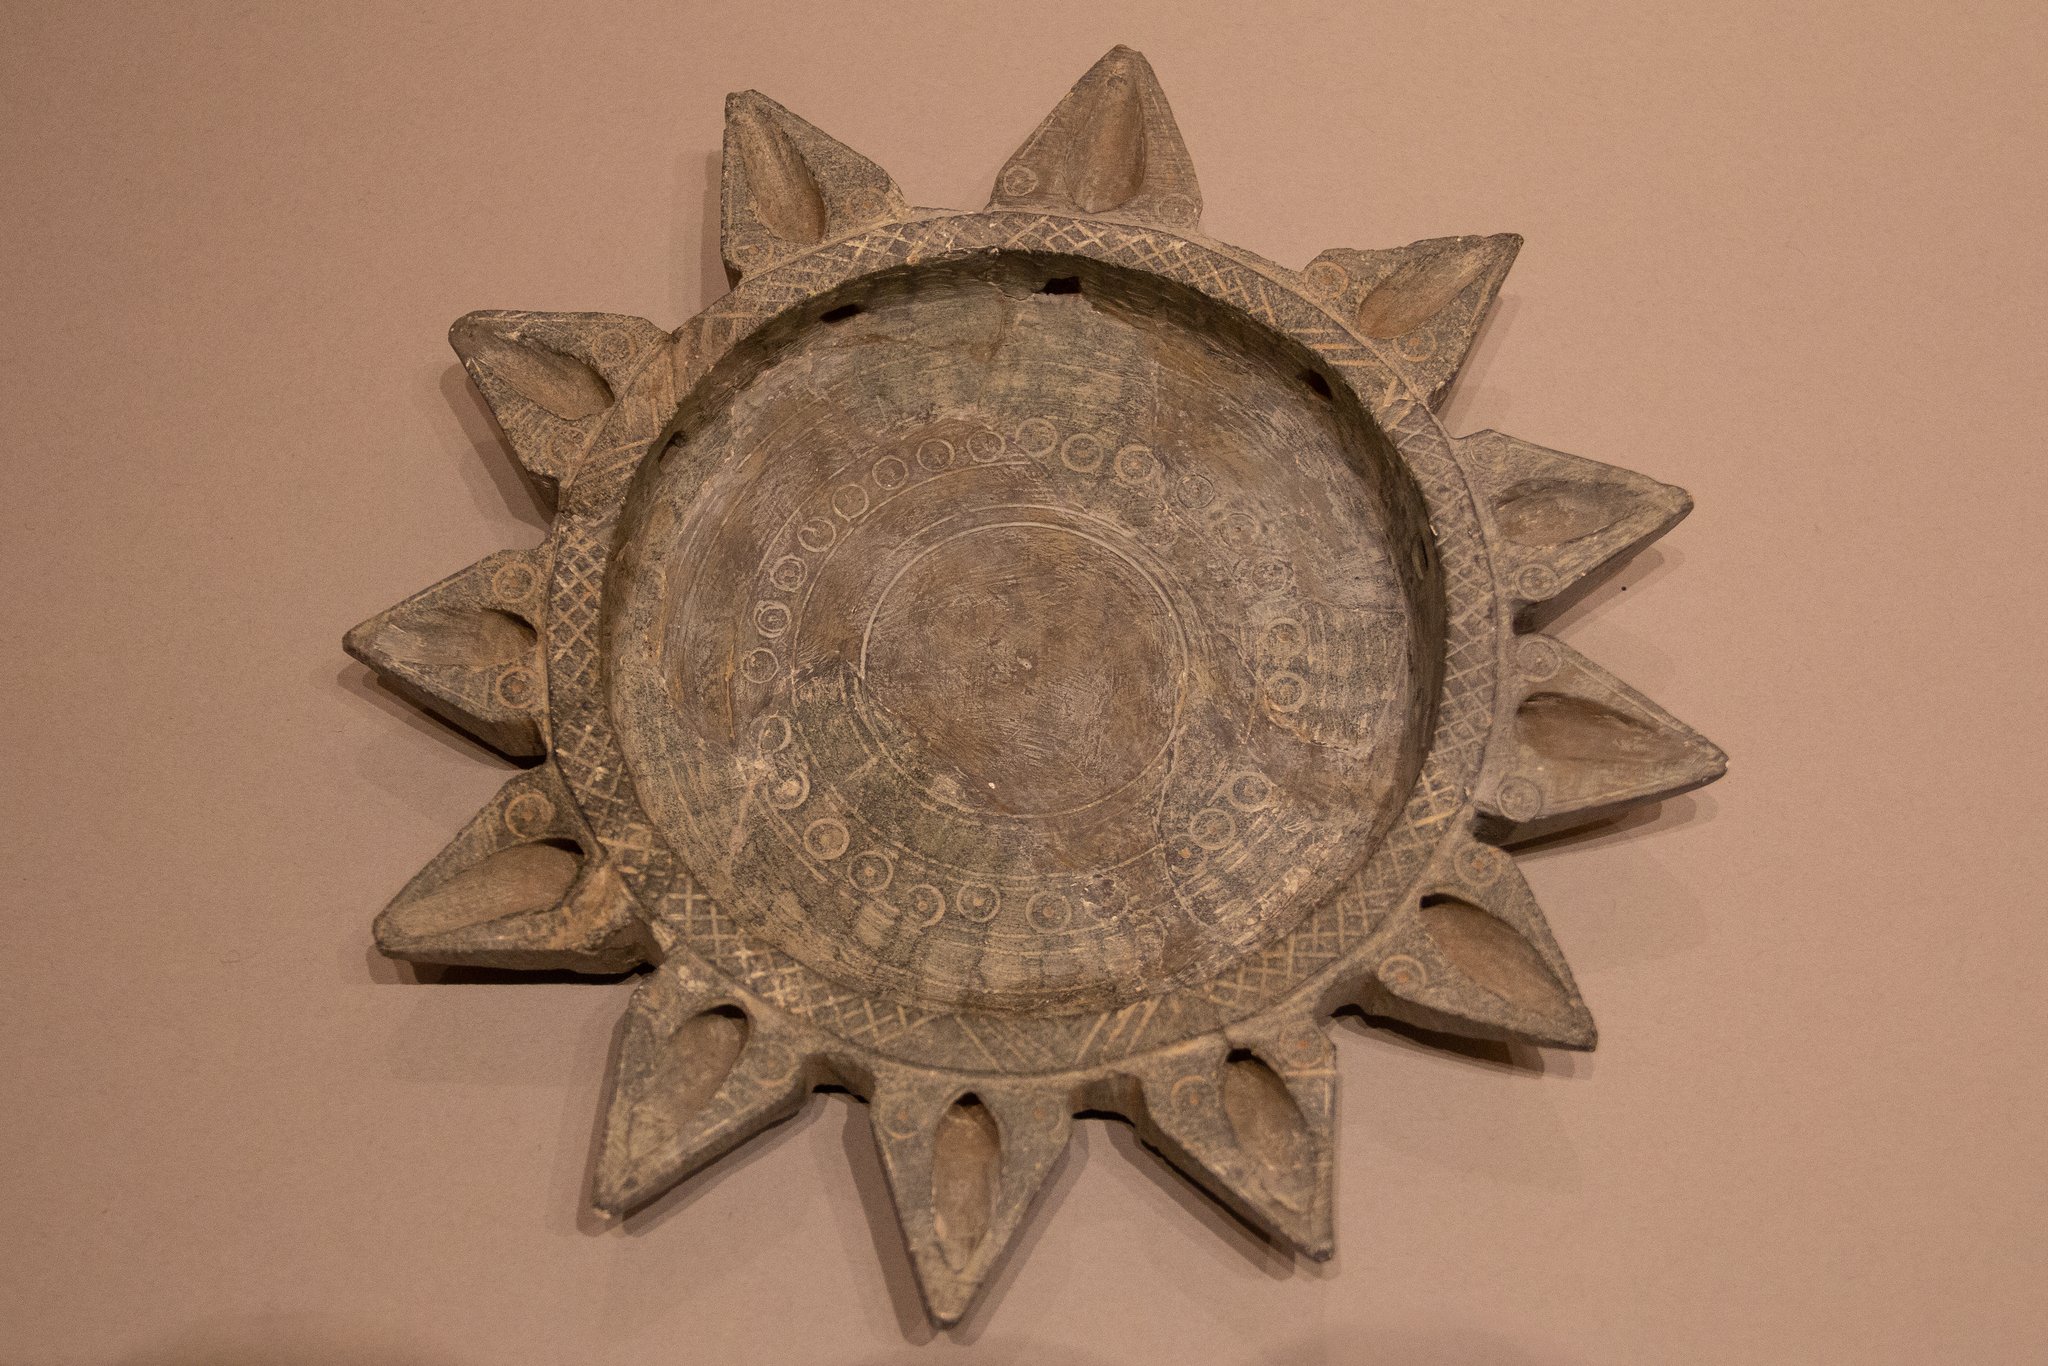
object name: lamp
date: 801-900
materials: stone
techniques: carving, incising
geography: iran